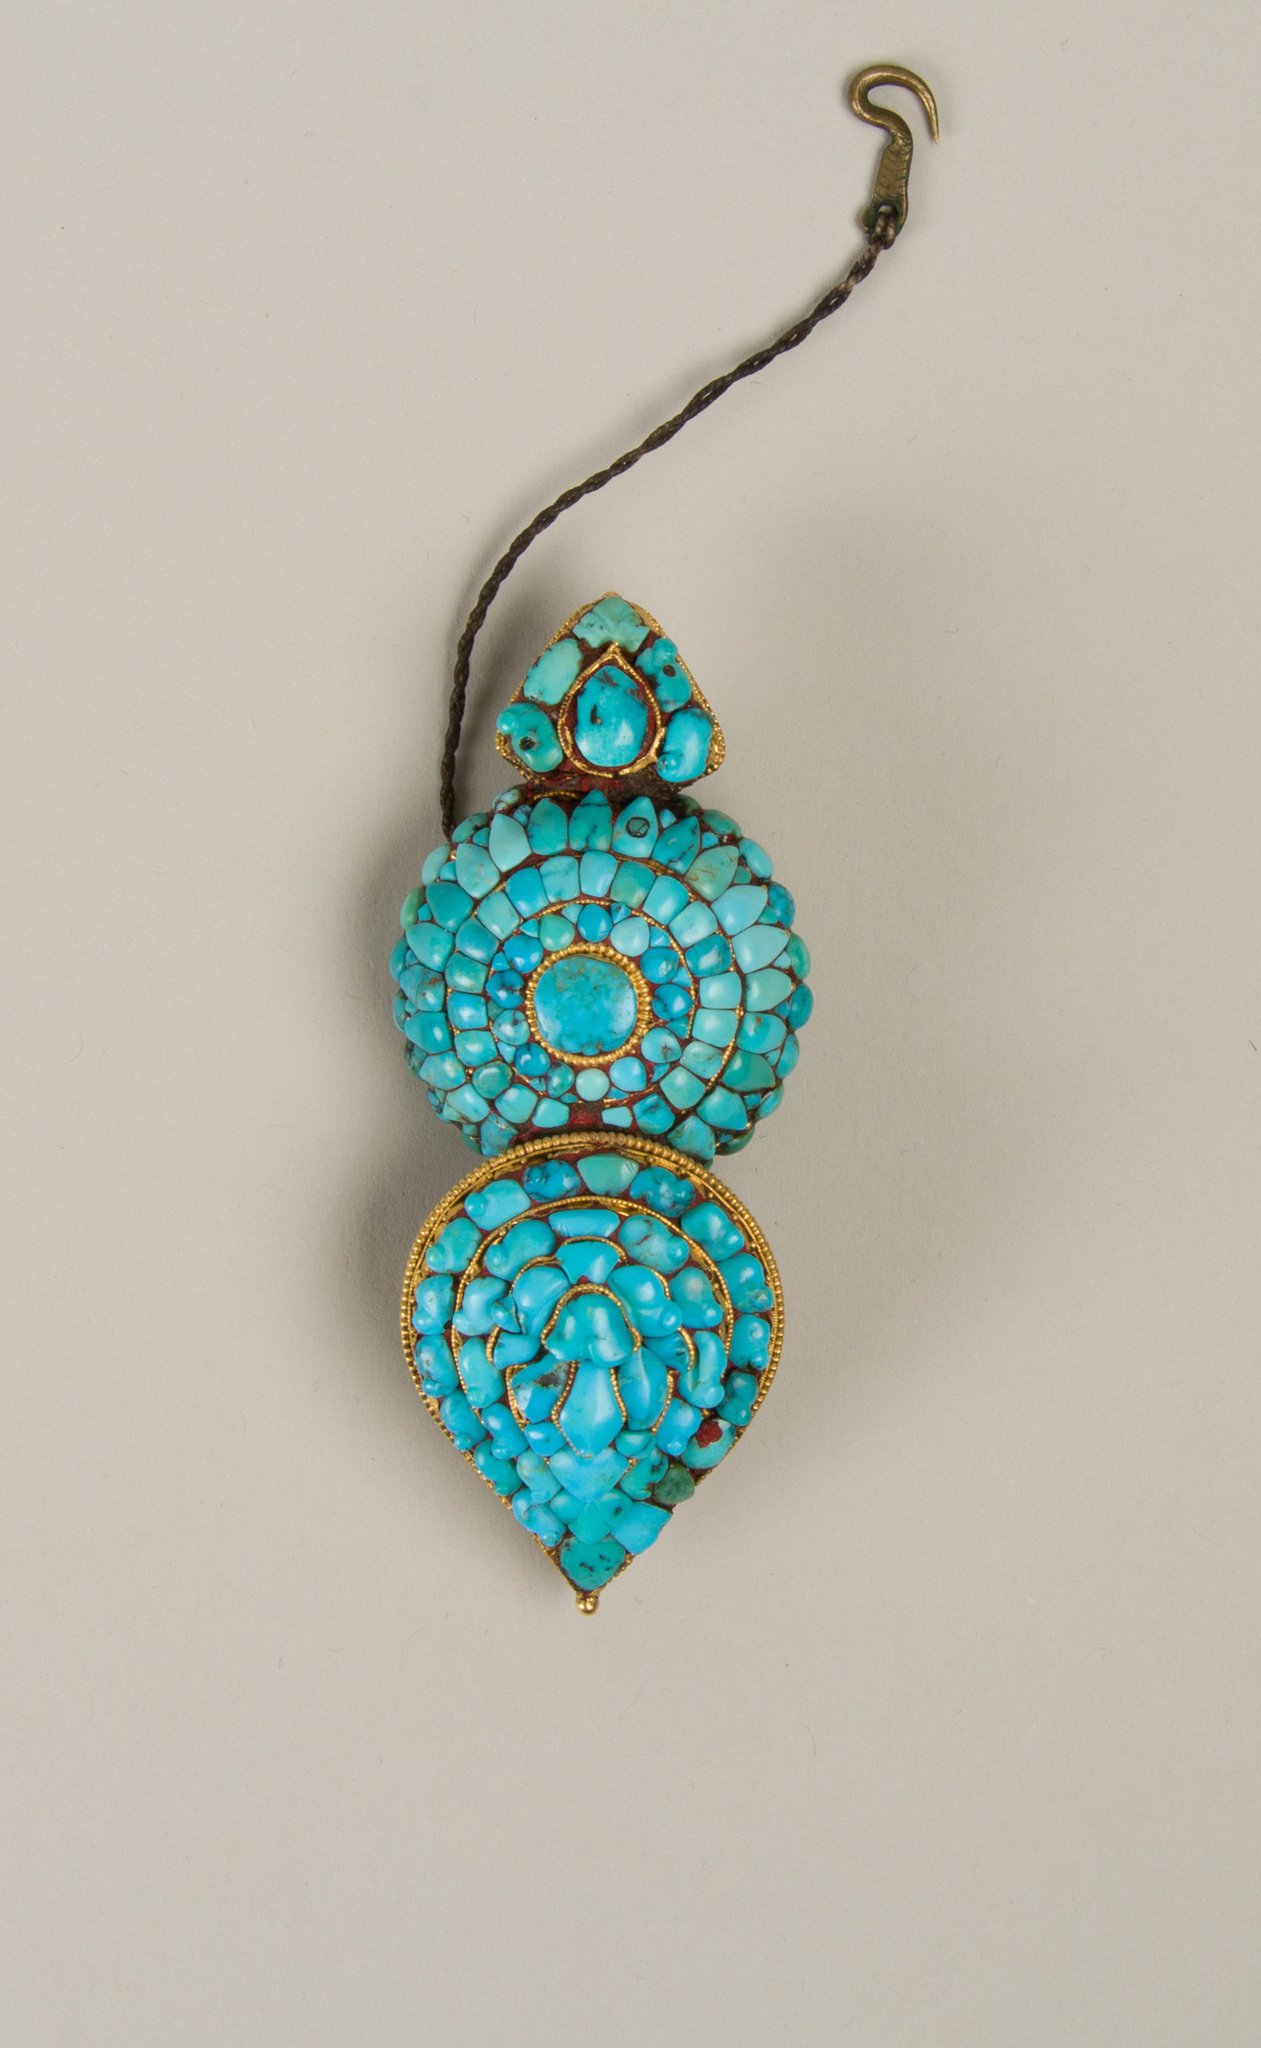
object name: earring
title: Woman's Earring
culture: tibet, lhasa area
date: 1801-1933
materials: gold